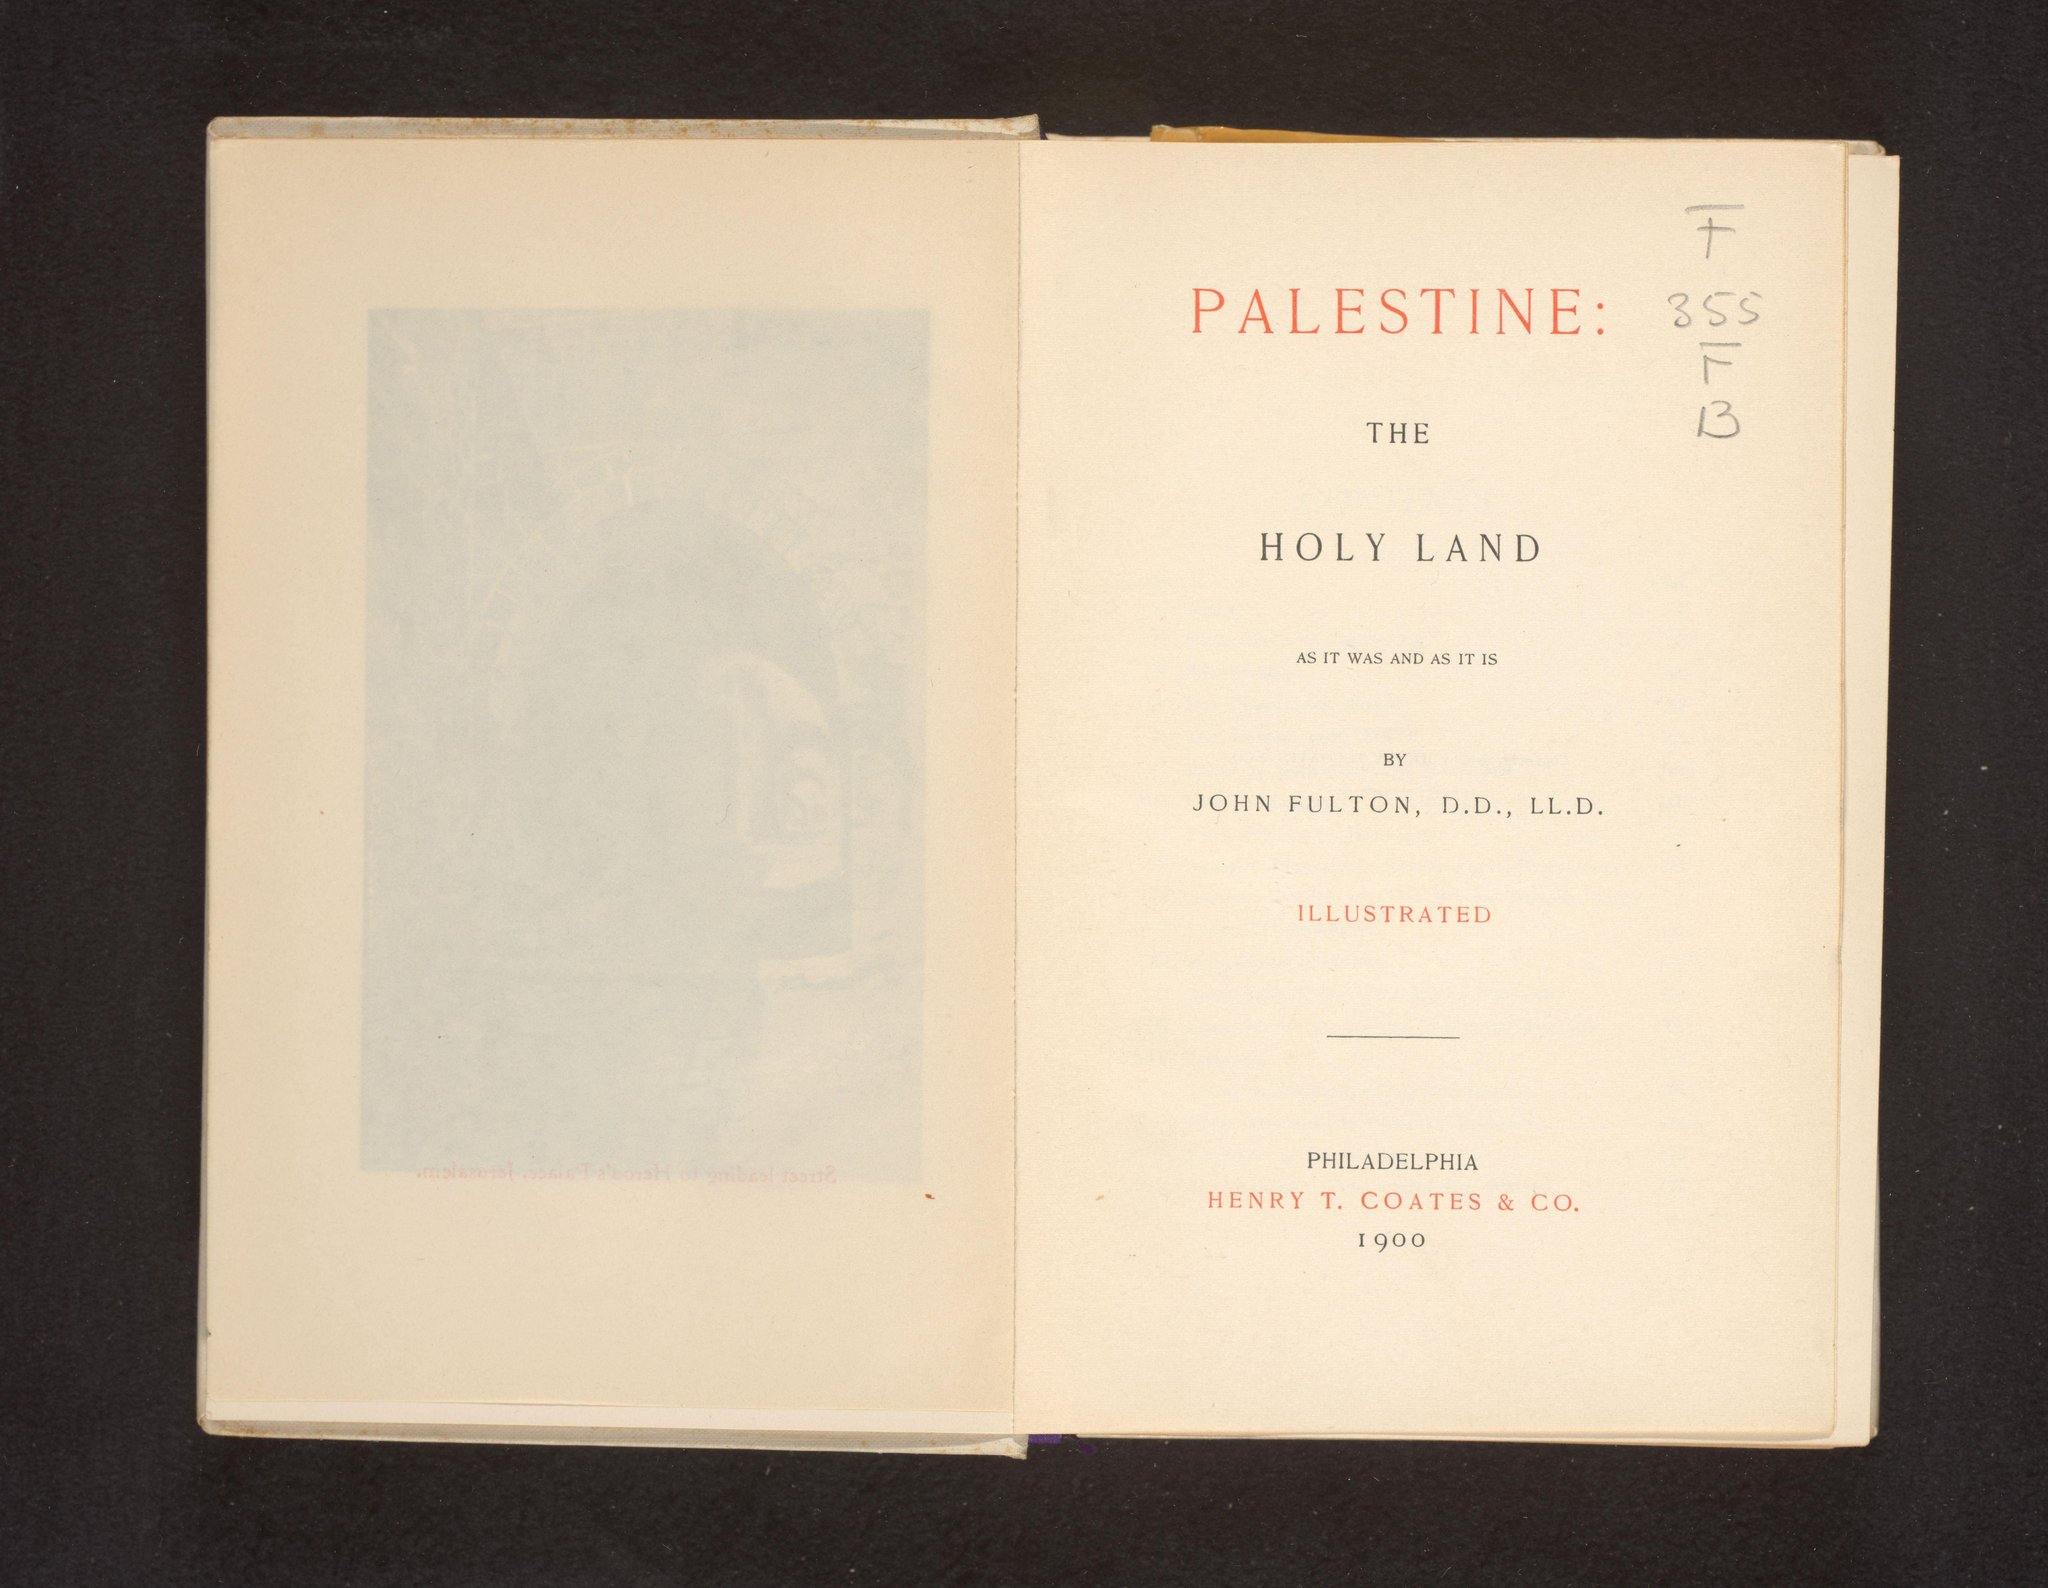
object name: book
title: Palestine: the Holy Land as it was and as it is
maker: john fulton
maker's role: schrijver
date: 1900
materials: cardboard, linen, paper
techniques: photoaquatint, printing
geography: philadelphia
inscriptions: inscription: ‘Ges. K. Halladay. Xenia. Ohio. Christmas 1904.’